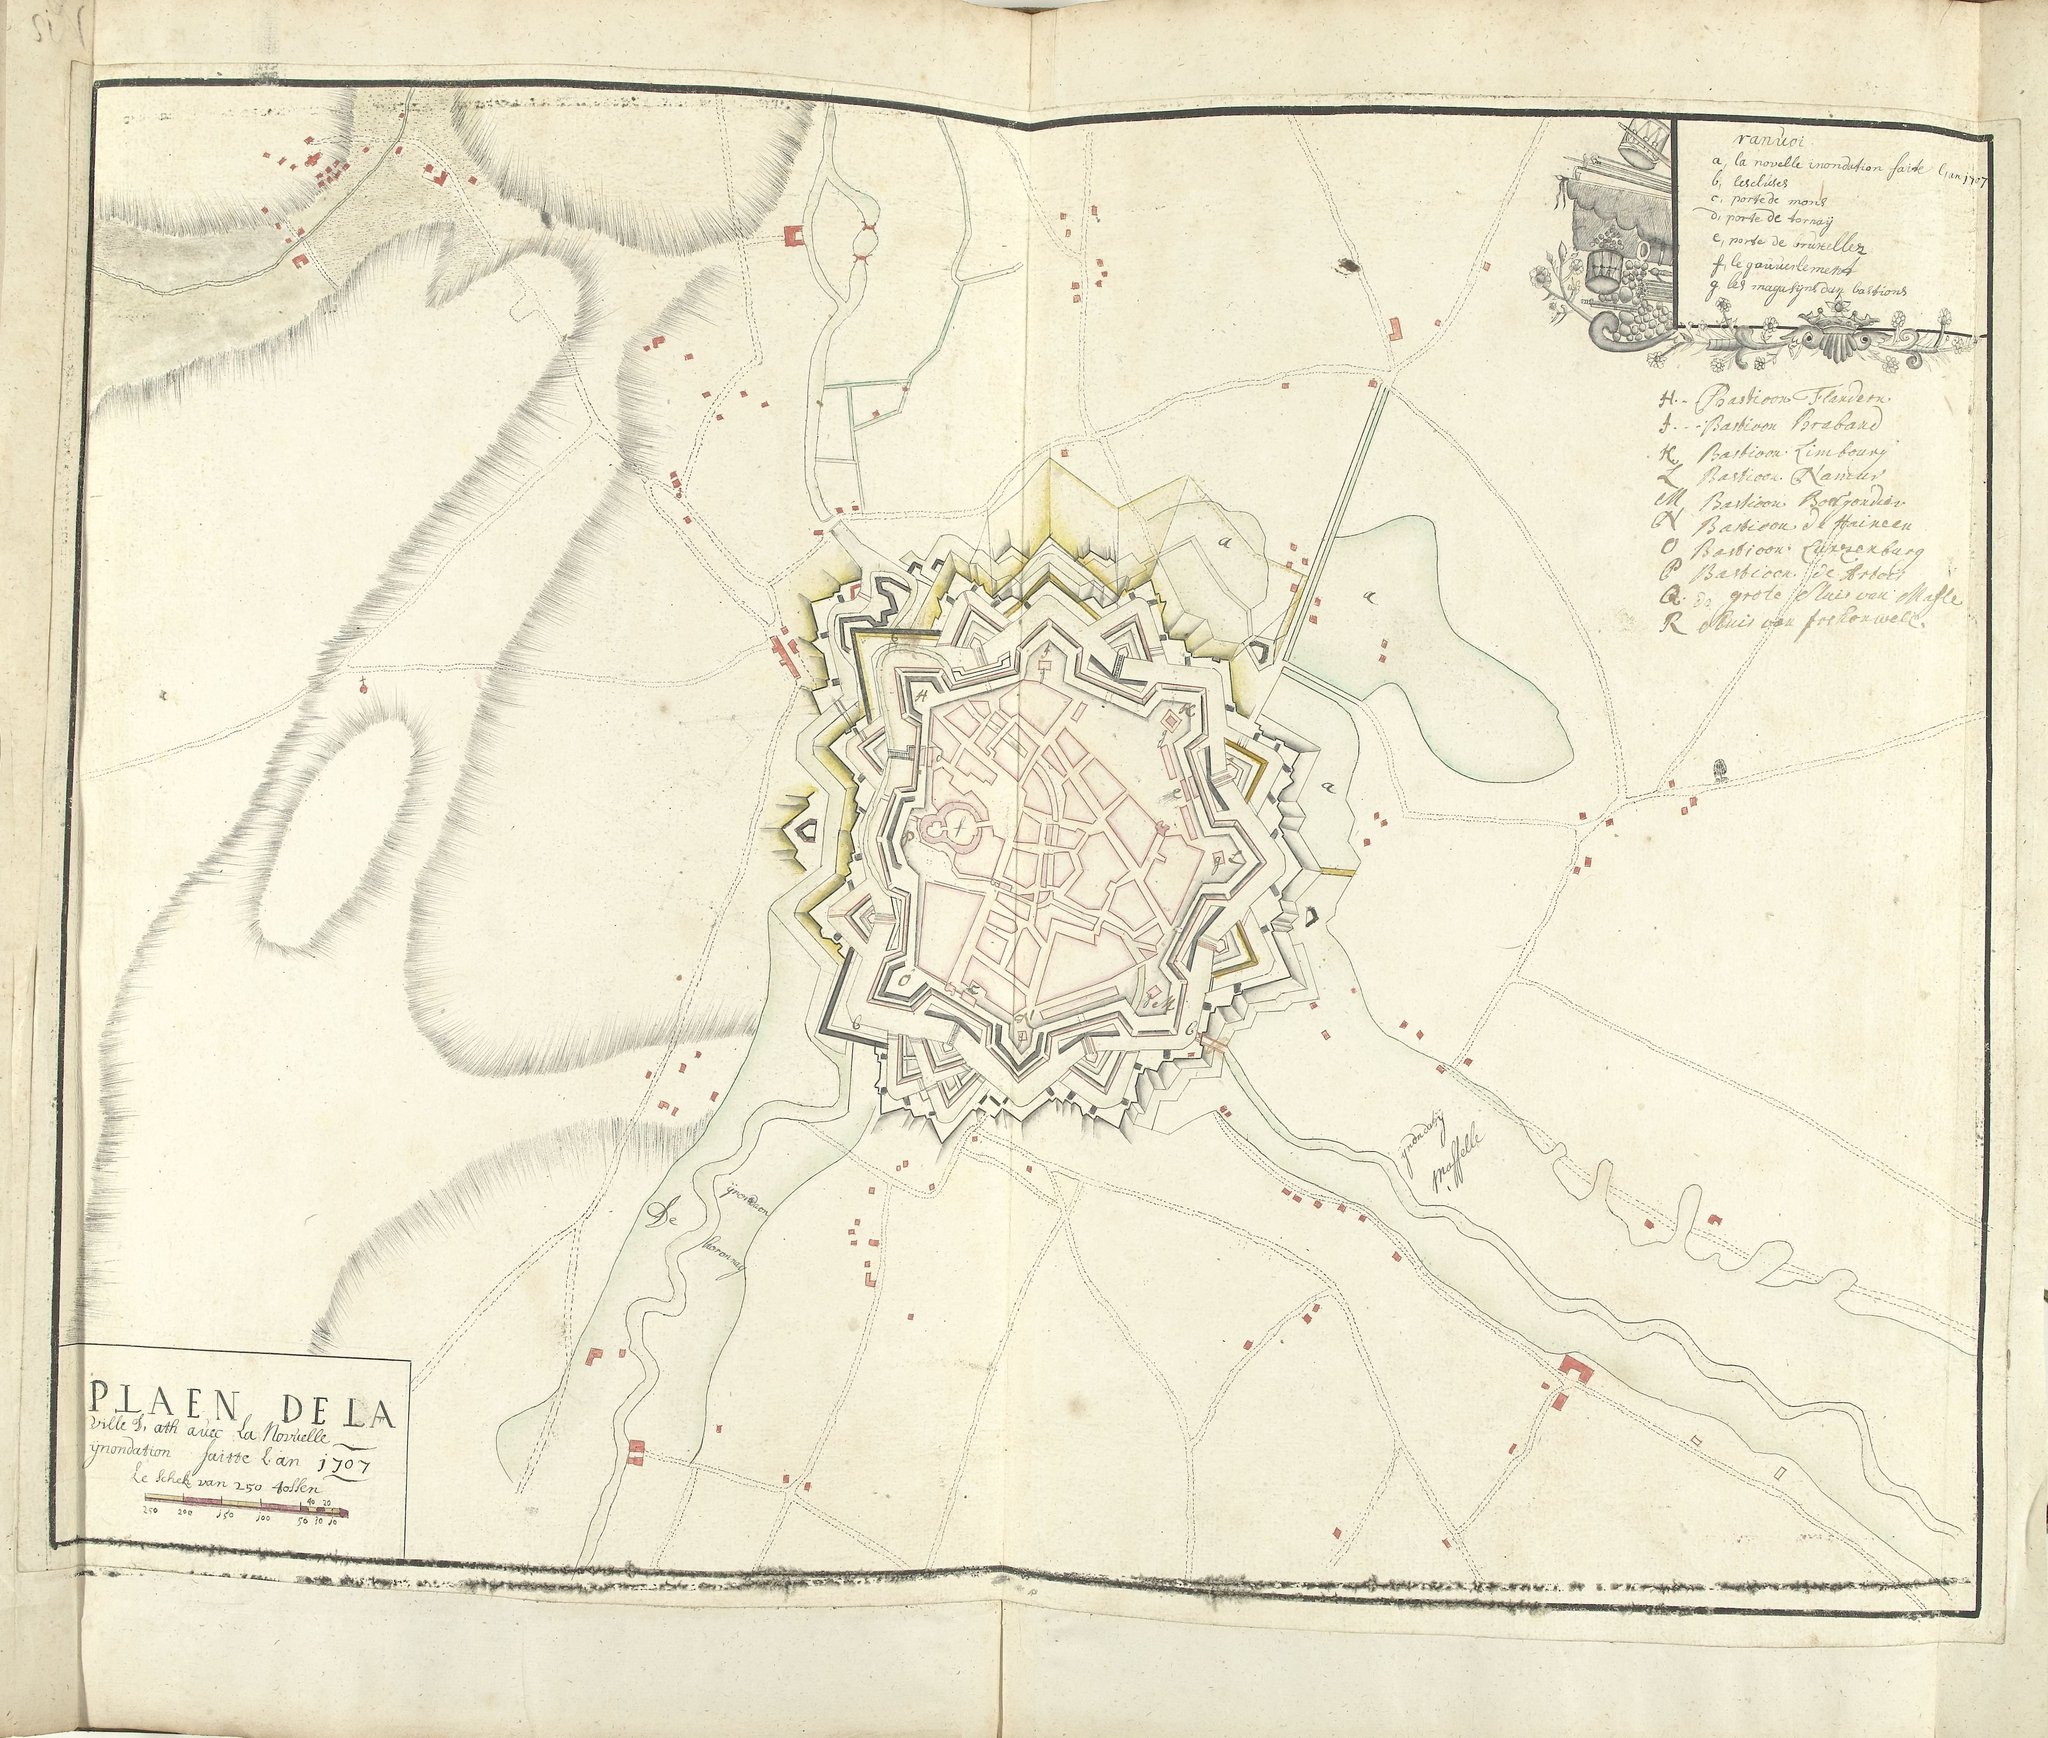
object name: drawing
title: Plaen de la ville d'Ath avec la Nouvelle ynondation faitte l'an 1707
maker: samuel du ry de champdoré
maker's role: draughtsman, engineer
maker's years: 1651-1729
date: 1707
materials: paper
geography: netherlands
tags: fortress, flood, maps of cities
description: Plattegrond van de versterkingen om de stad Ath, met de inundaties in het jaar 1707. Rechtsboven een cartouche met de legenda a-R in het Frans en Nederlands. Onderdeel van een verzameling getekende plannen van versterkte plaatsen in Nederland en omringende landen ten tijde van de Spaanse Successieoorlog (deel C).